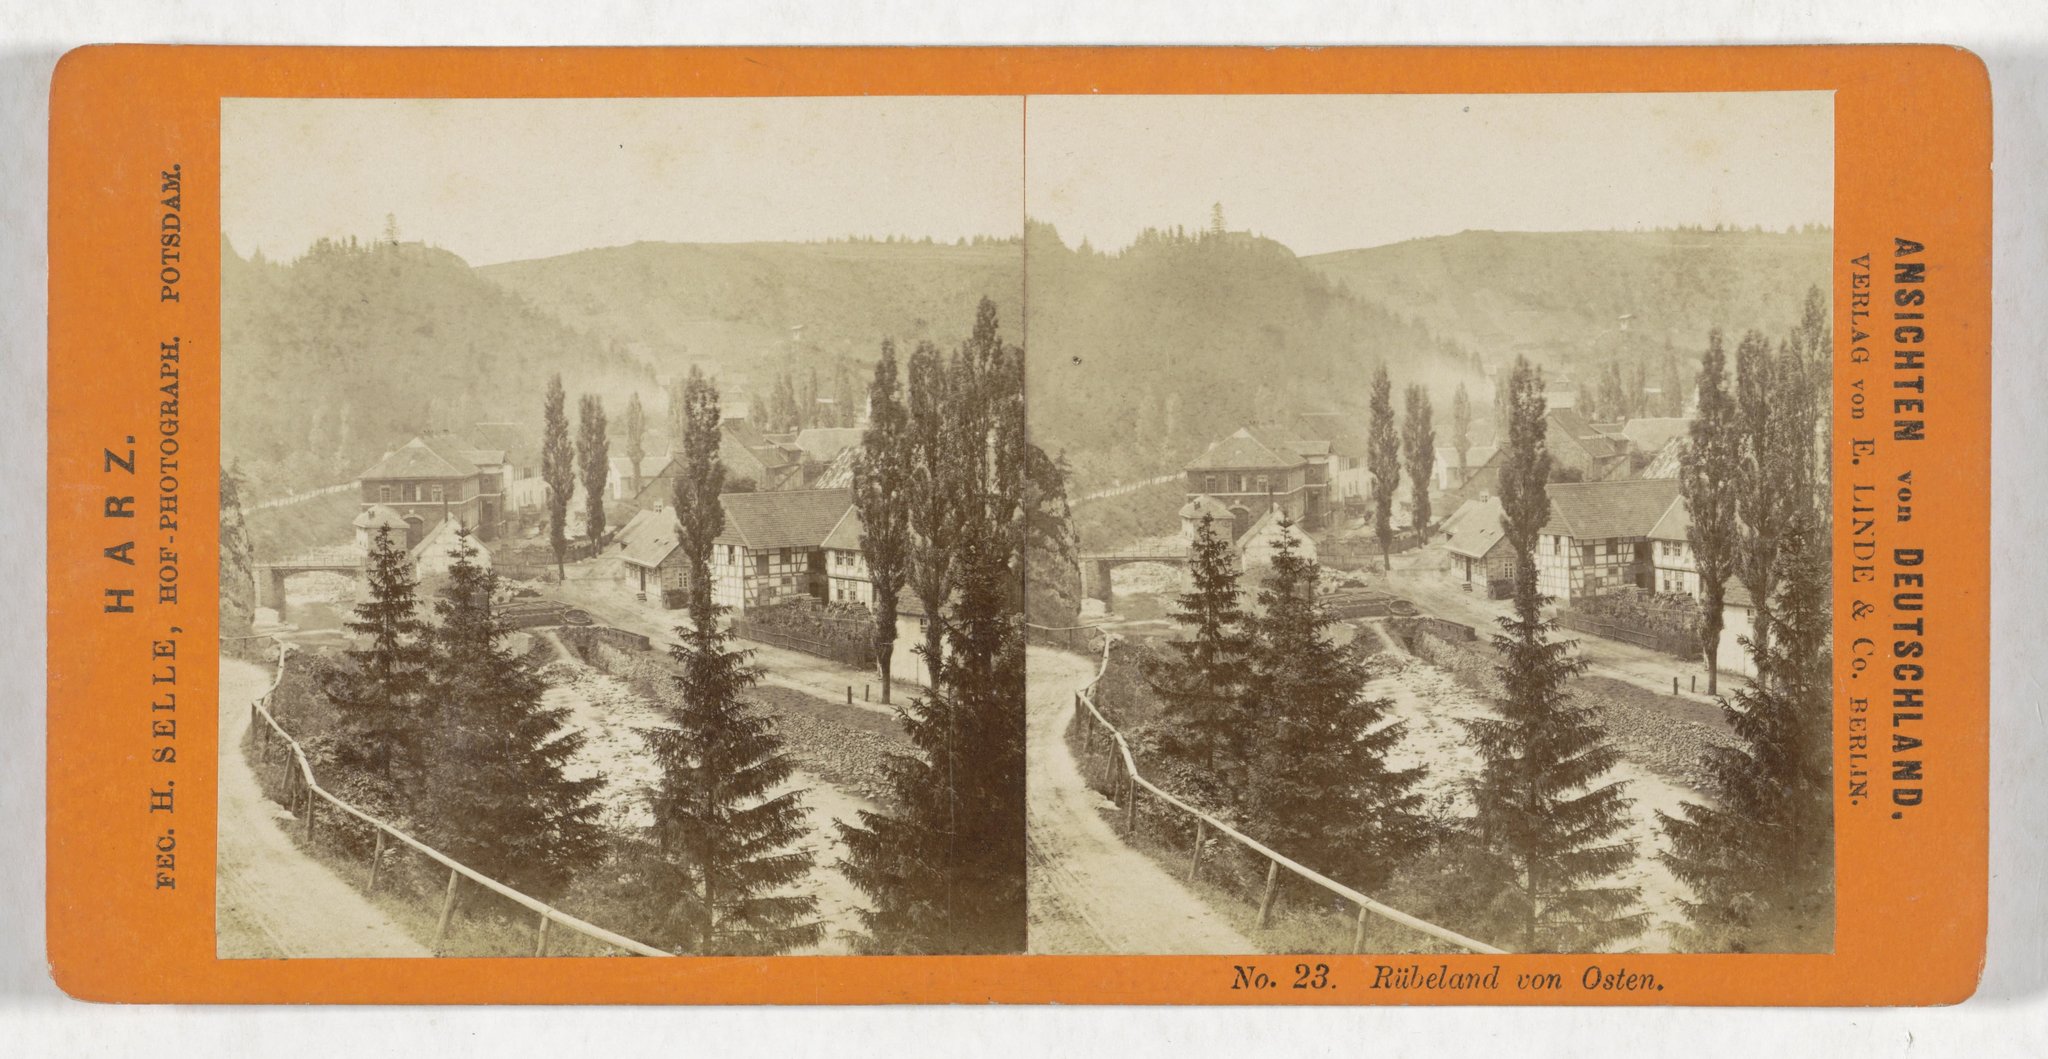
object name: stereograph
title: Rübeland von Osten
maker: hermann selle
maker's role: fotograaf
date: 1868-1890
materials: cardboard, paper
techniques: albumen print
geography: berlin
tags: village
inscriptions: inscription: ‘No. 23. Harz. Rübeland an der Bode./ Rübeland ist ein grosses braunschweigisches Hüttenwerk (...) die Arbeiter ruft. (W.Riehl)’, inscription: ‘Hof-Photograph. Potsdam.’, number: ‘No. 23.’